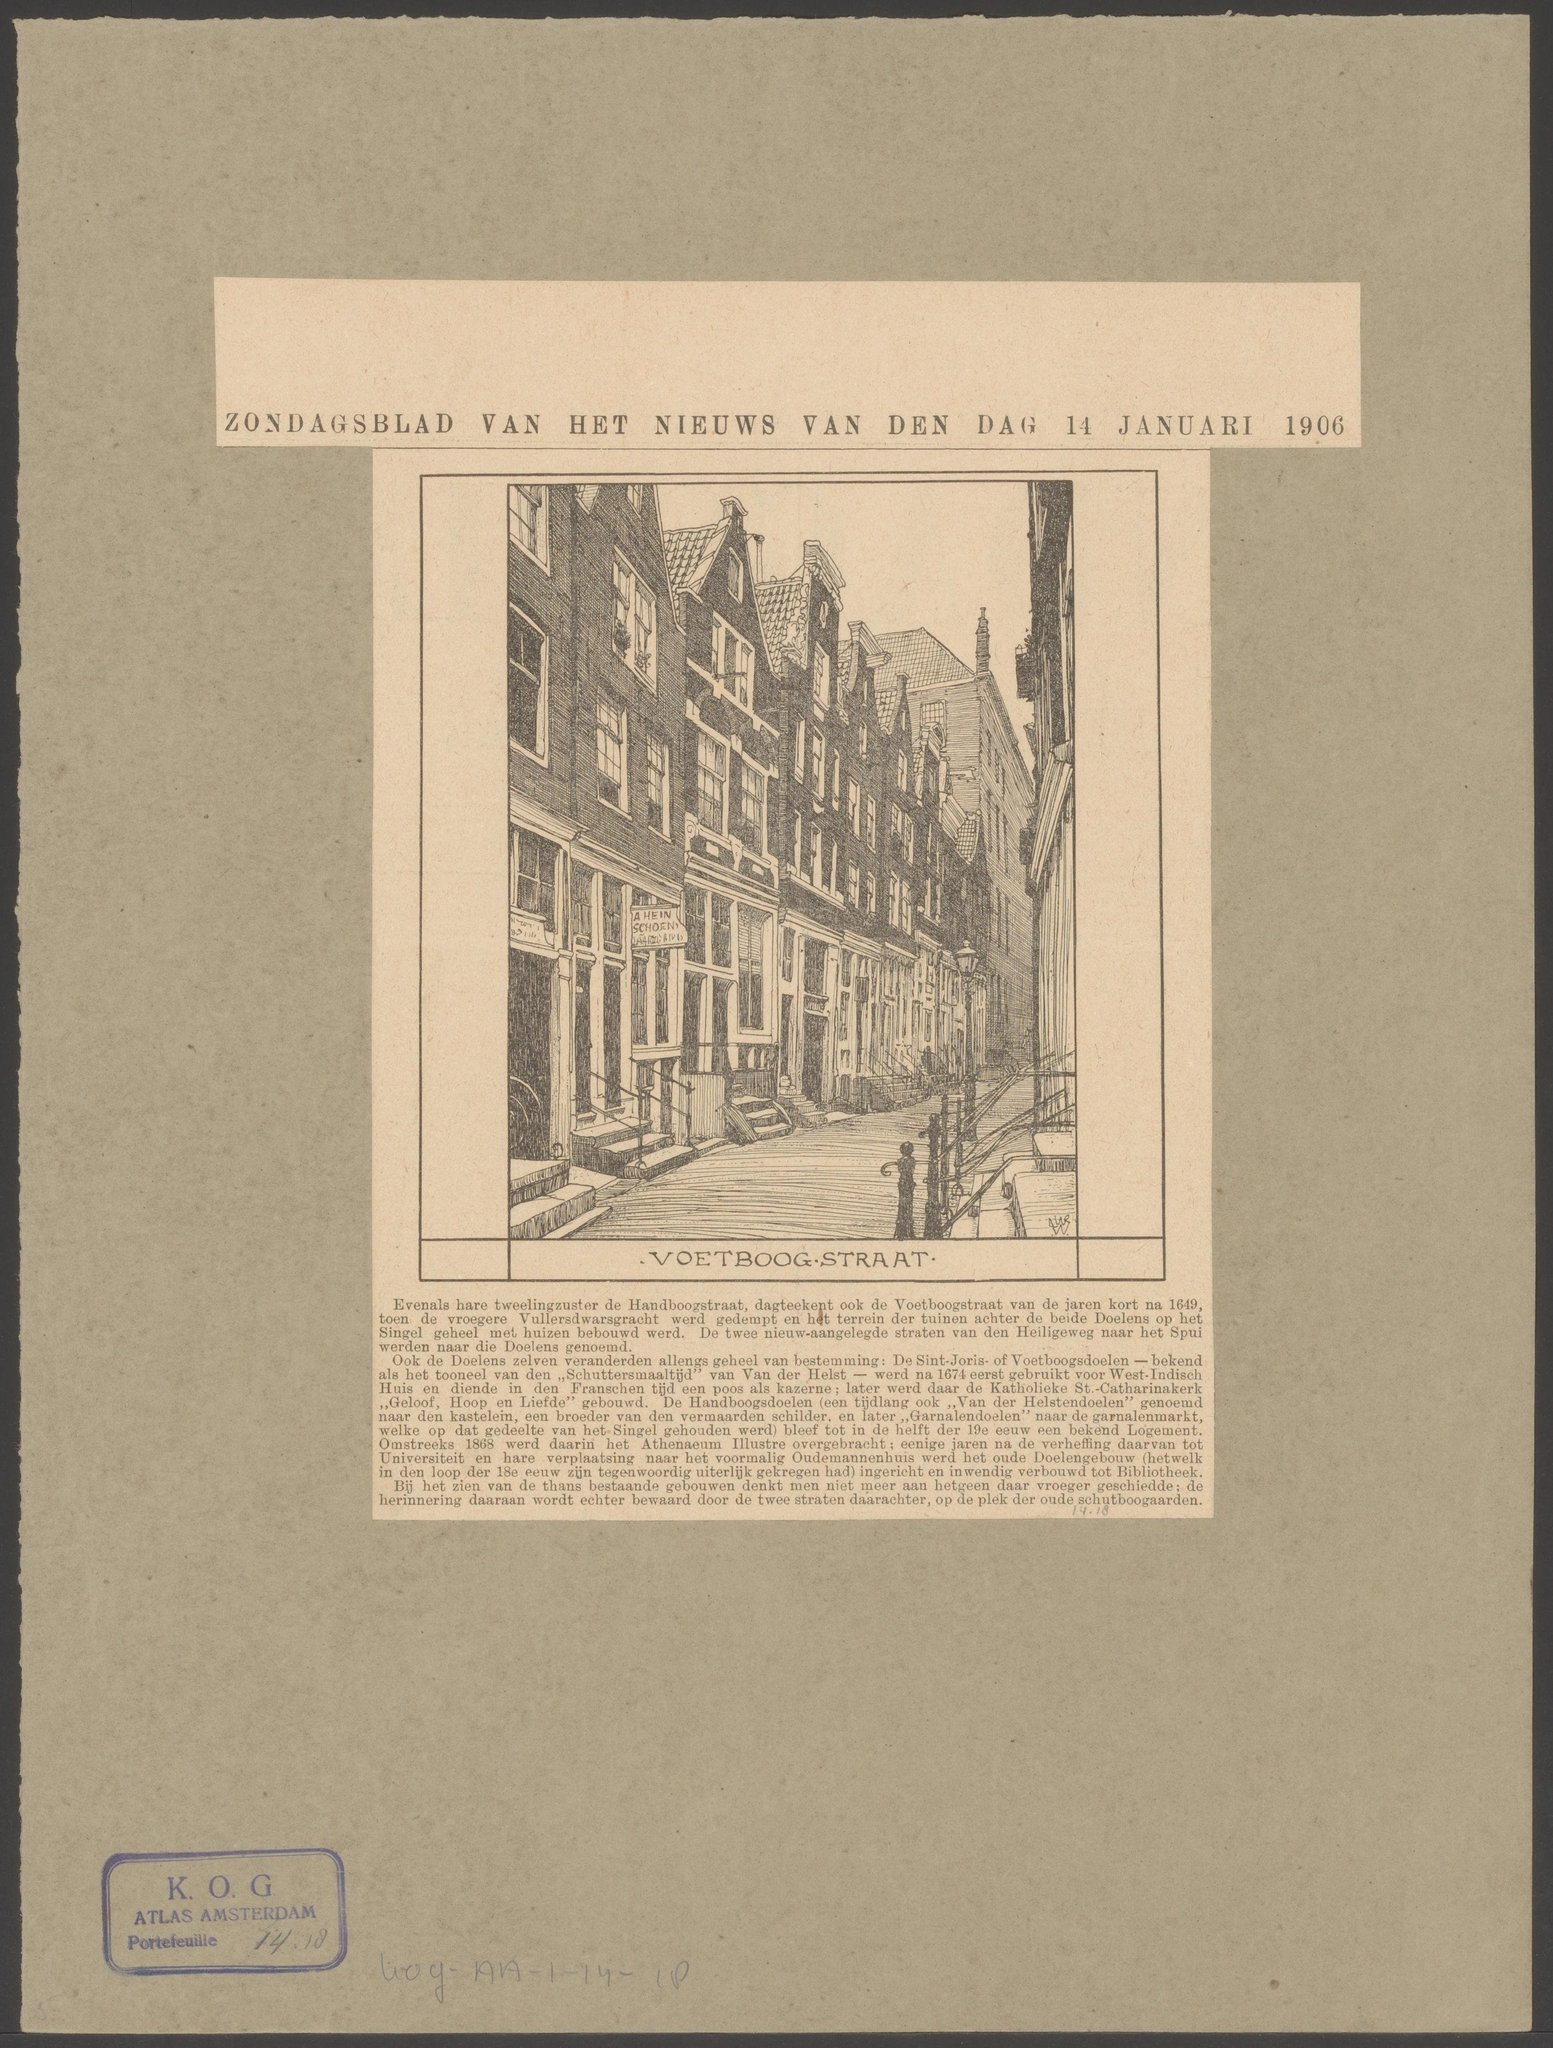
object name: photomechanical print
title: Oud-Amsterdam 100 Stadsgezichten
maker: willem wenckebach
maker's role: designer, draughtsman, painter, print maker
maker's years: 1860-1937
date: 1906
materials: paper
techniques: letterpress printing, line block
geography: amsterdam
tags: city-view in general; 'veduta', the usual house or row of houses, street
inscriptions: collector's mark: ‘14.18’ Lugt 1641b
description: Onderwerpsrubriek binnen de Atlas Amsterdam: Verhulststraat (Johannes), Viaducten, Vierwindenstraat, Vinkenbuurt, Vinkenpad, Vinkenstraat, Vischsteeg, Vliegendesteeg, Voetboogstraat, Volewijk, Vondelstraat, Voorburgwal (N.Z.).